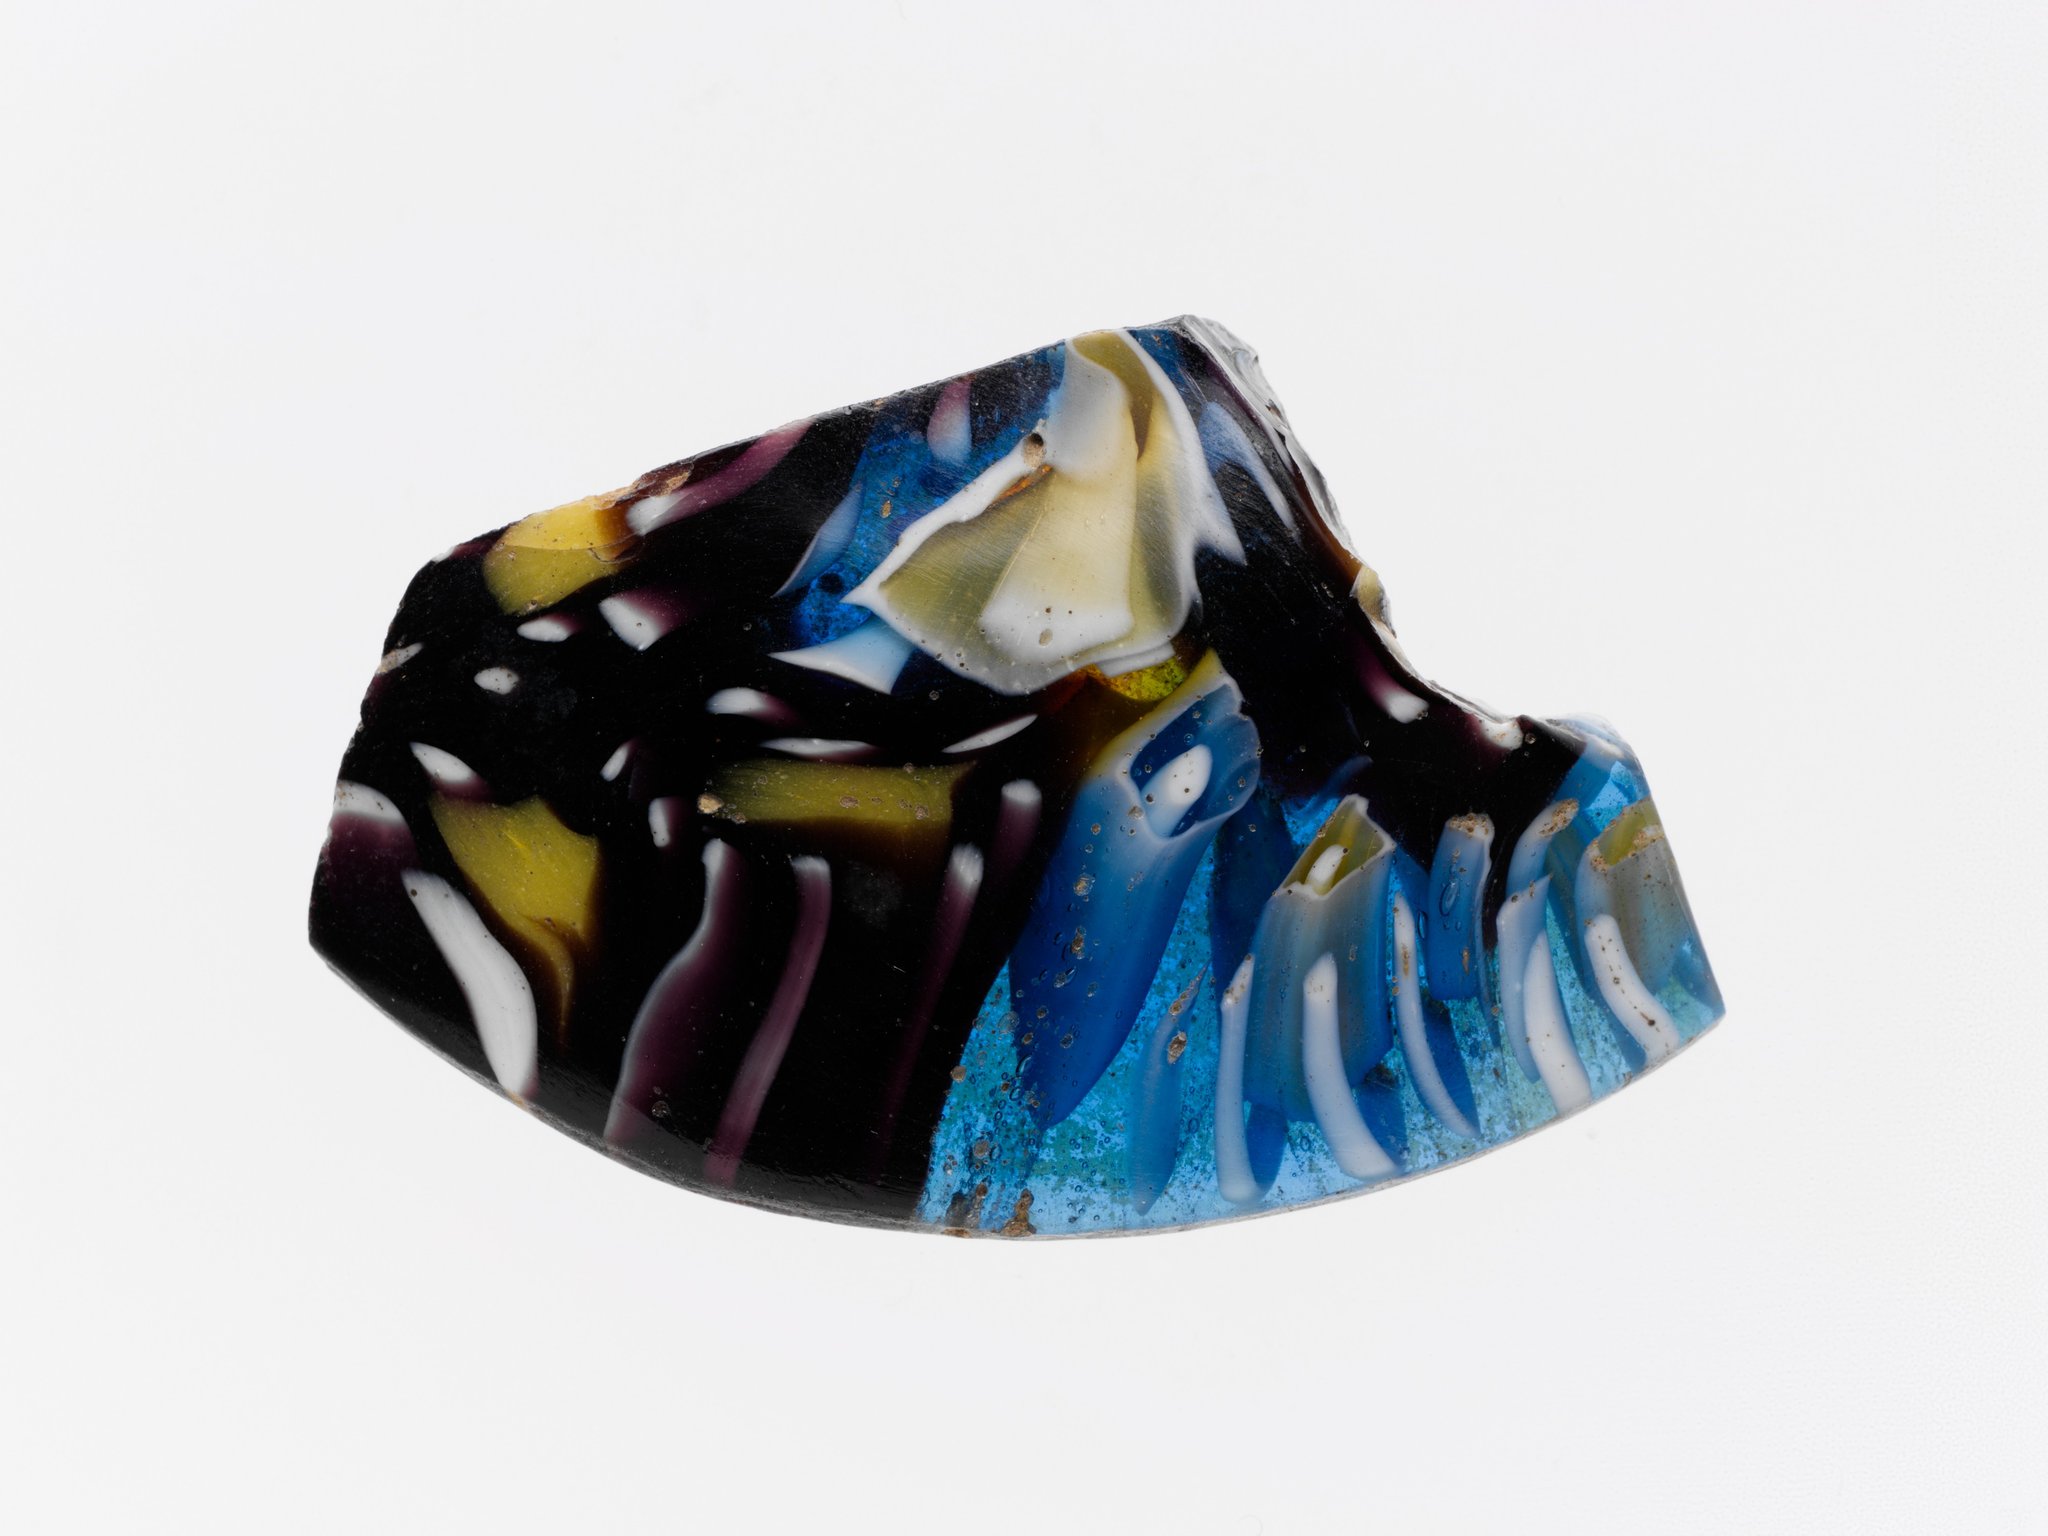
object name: fragment, mosaic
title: Glass mosaic base ring fragment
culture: roman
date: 34 BCE-33 CE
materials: glass